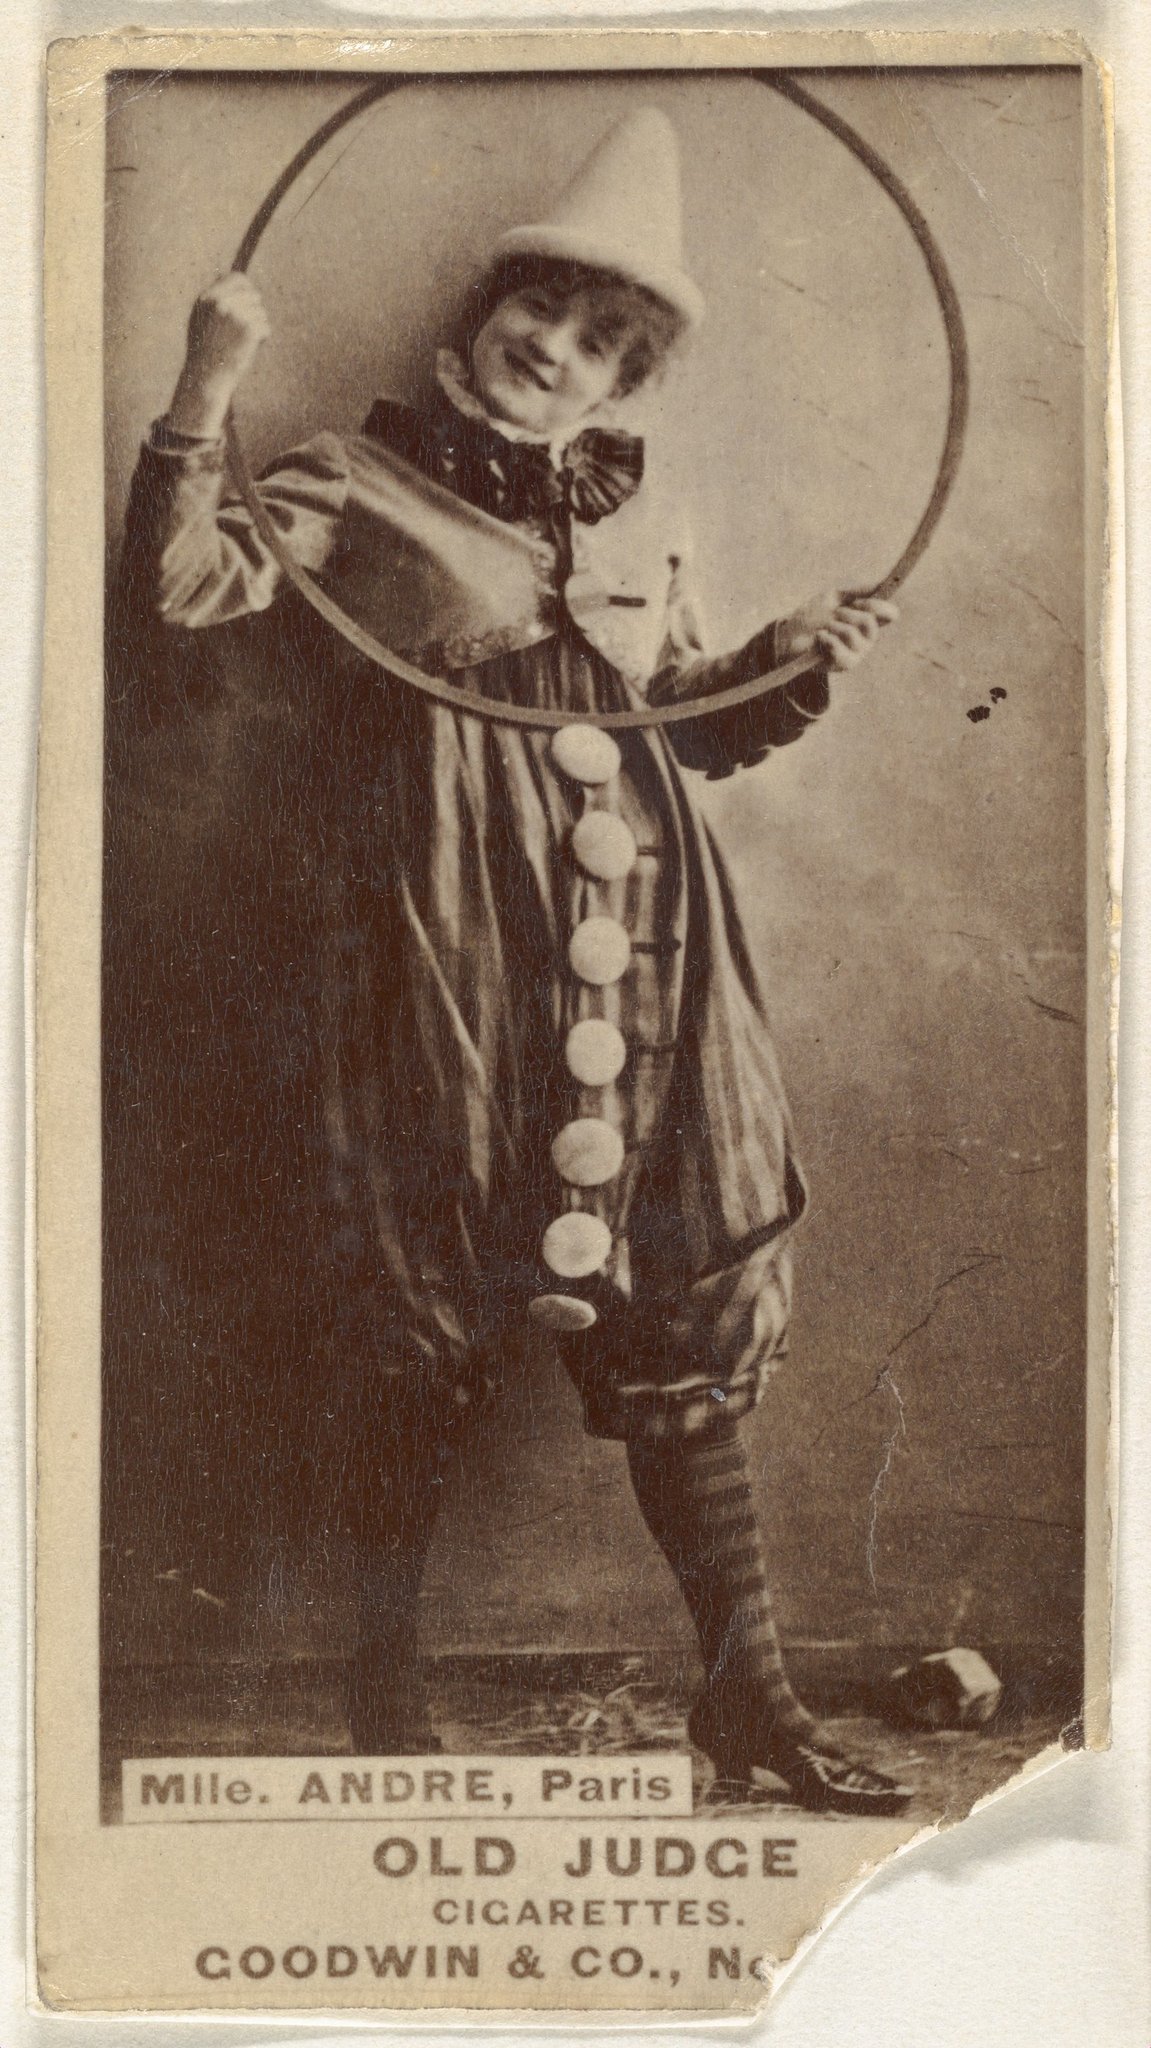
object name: photograph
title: Mlle. Andre, Paris, from the Actors and Actresses series (N171) for Old Judge Cigarettes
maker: goodwin & company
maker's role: publisher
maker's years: 1850-1950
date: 1886-1890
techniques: albumen silver print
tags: portraits,women,actresses